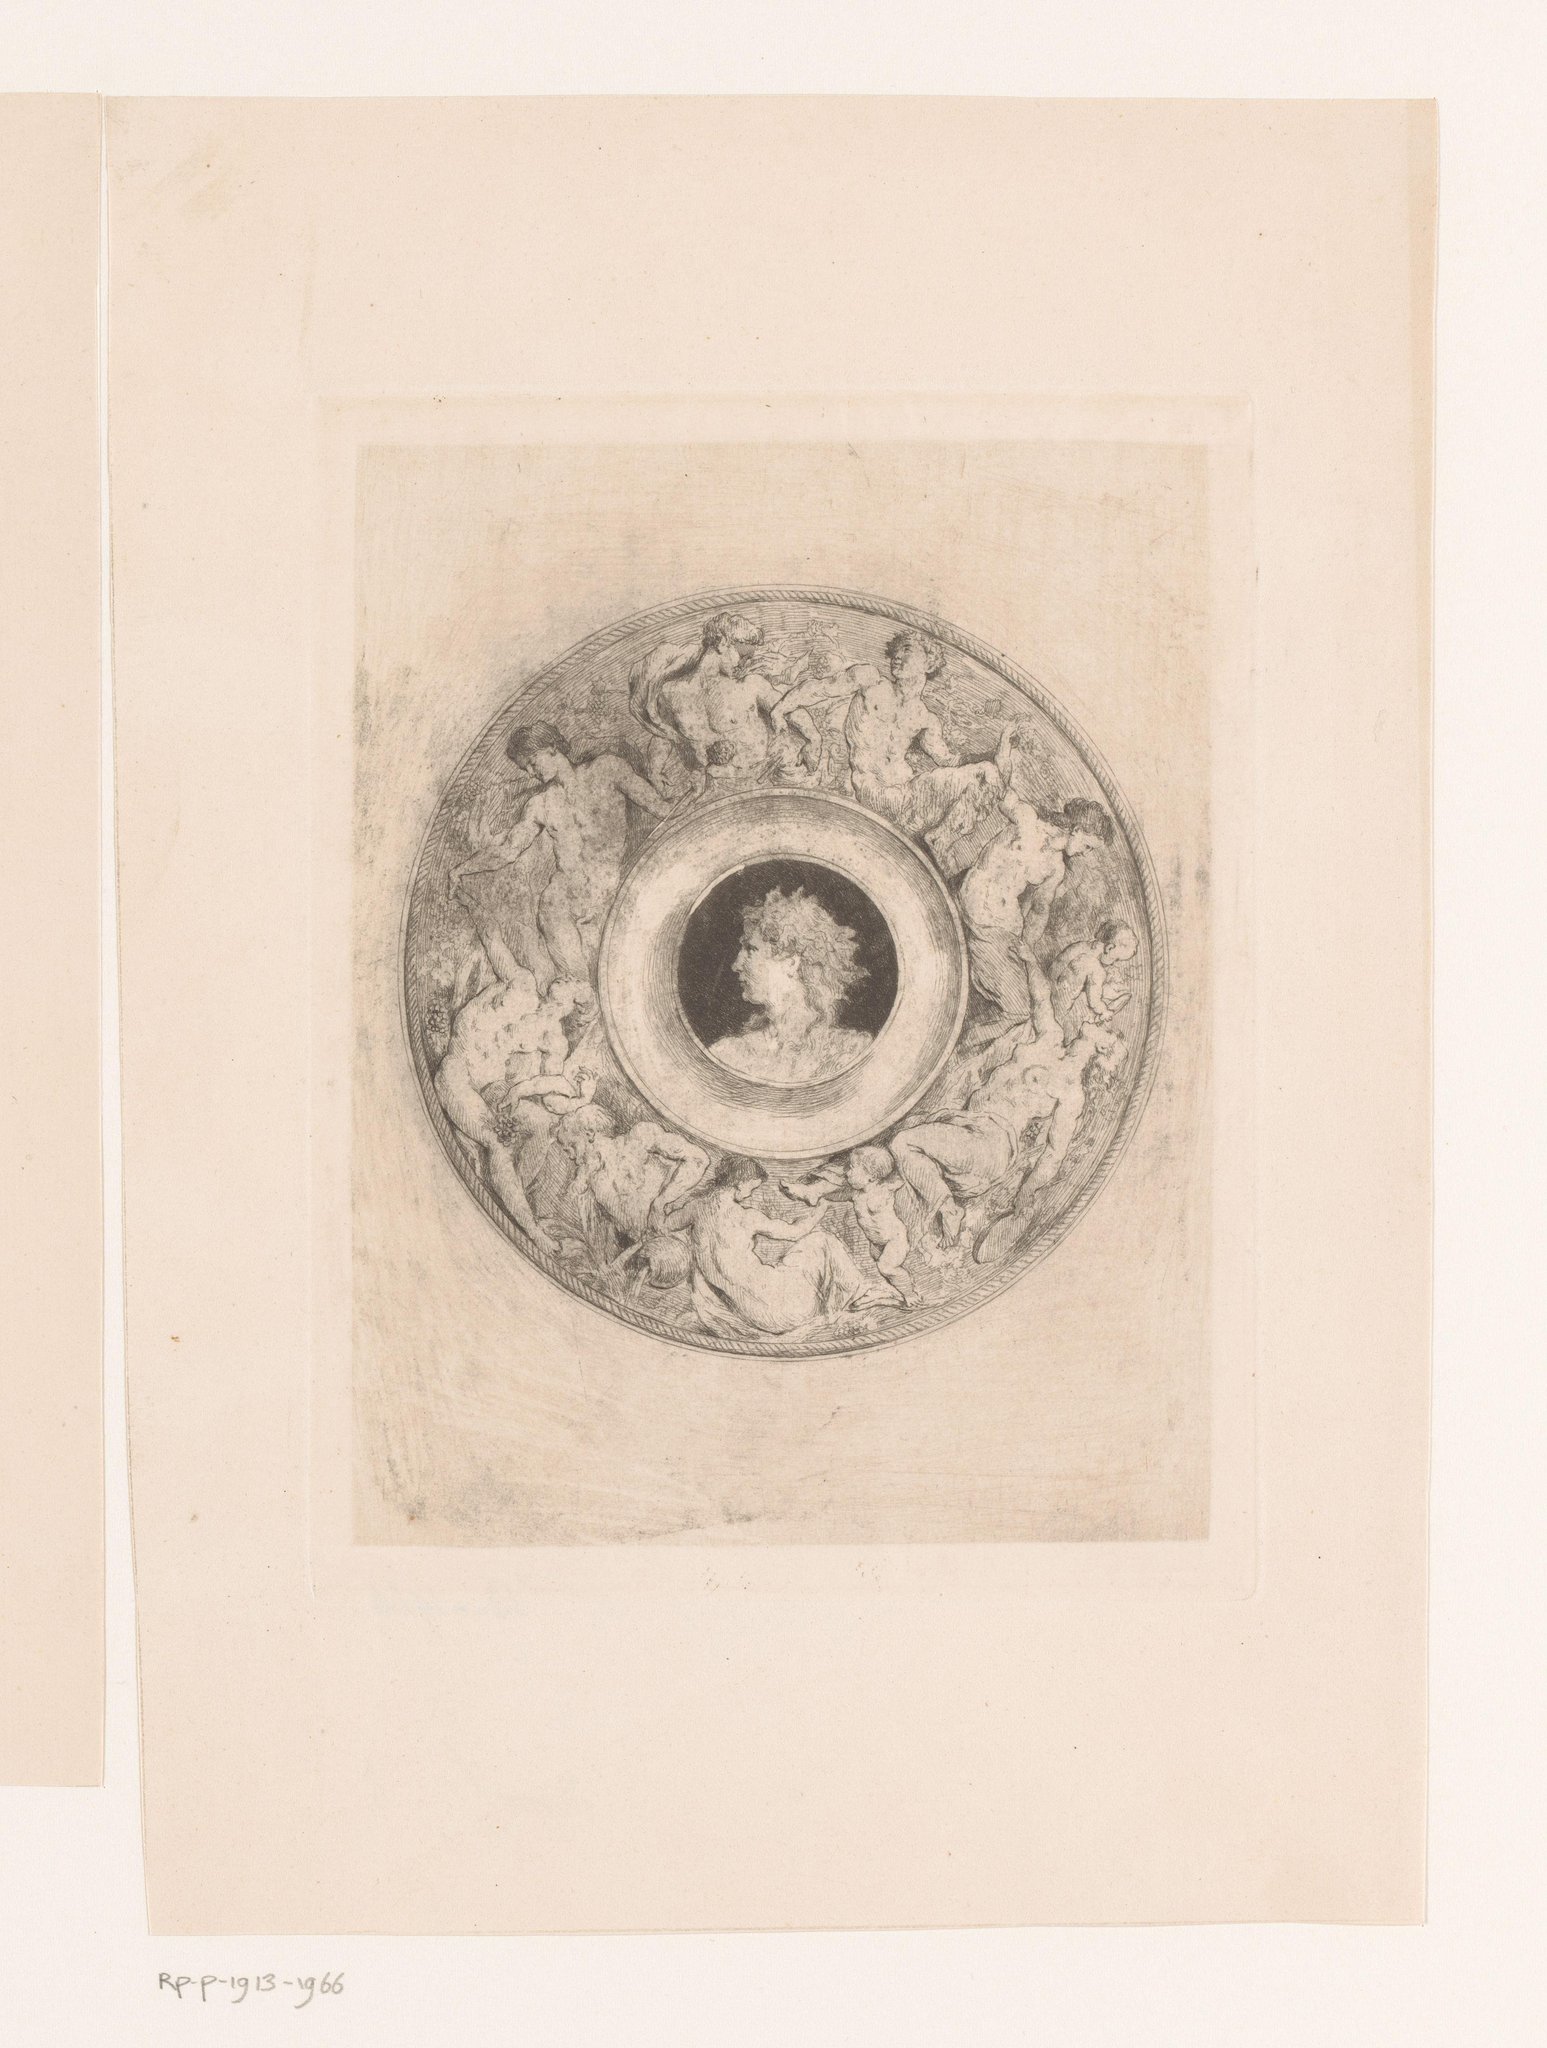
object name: print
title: Ontwerp voor een schotel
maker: adolphe léonard de mol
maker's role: print maker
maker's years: 1834-1877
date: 1878-1879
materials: paper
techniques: etching, intaglio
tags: (story of) bacchus (dionysus), liber, postures of the human figure, bunch of grapes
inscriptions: collector's mark: Lugt 2228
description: Prent mogelijk verschenen in: Album du journal des Beaux-Arts, dix eaux-fortes inédites. Brussel, Parijs, Leipzig: s.n., 1878-1879.